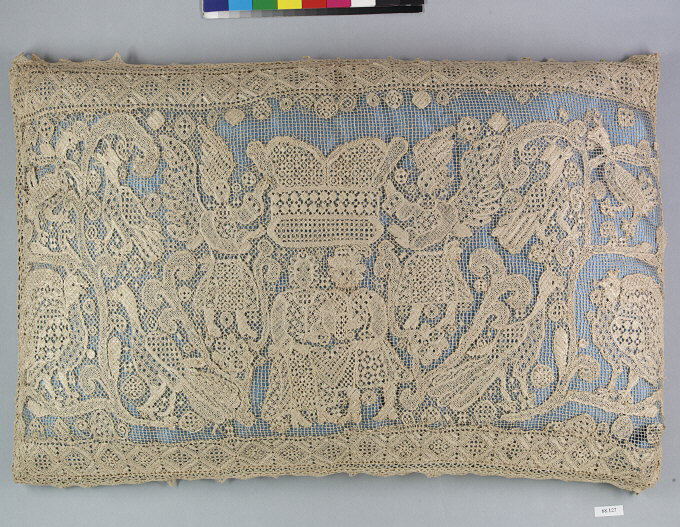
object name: pillow cover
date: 1801-1833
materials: linen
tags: human figures,birds,peacocks,angels,crowns